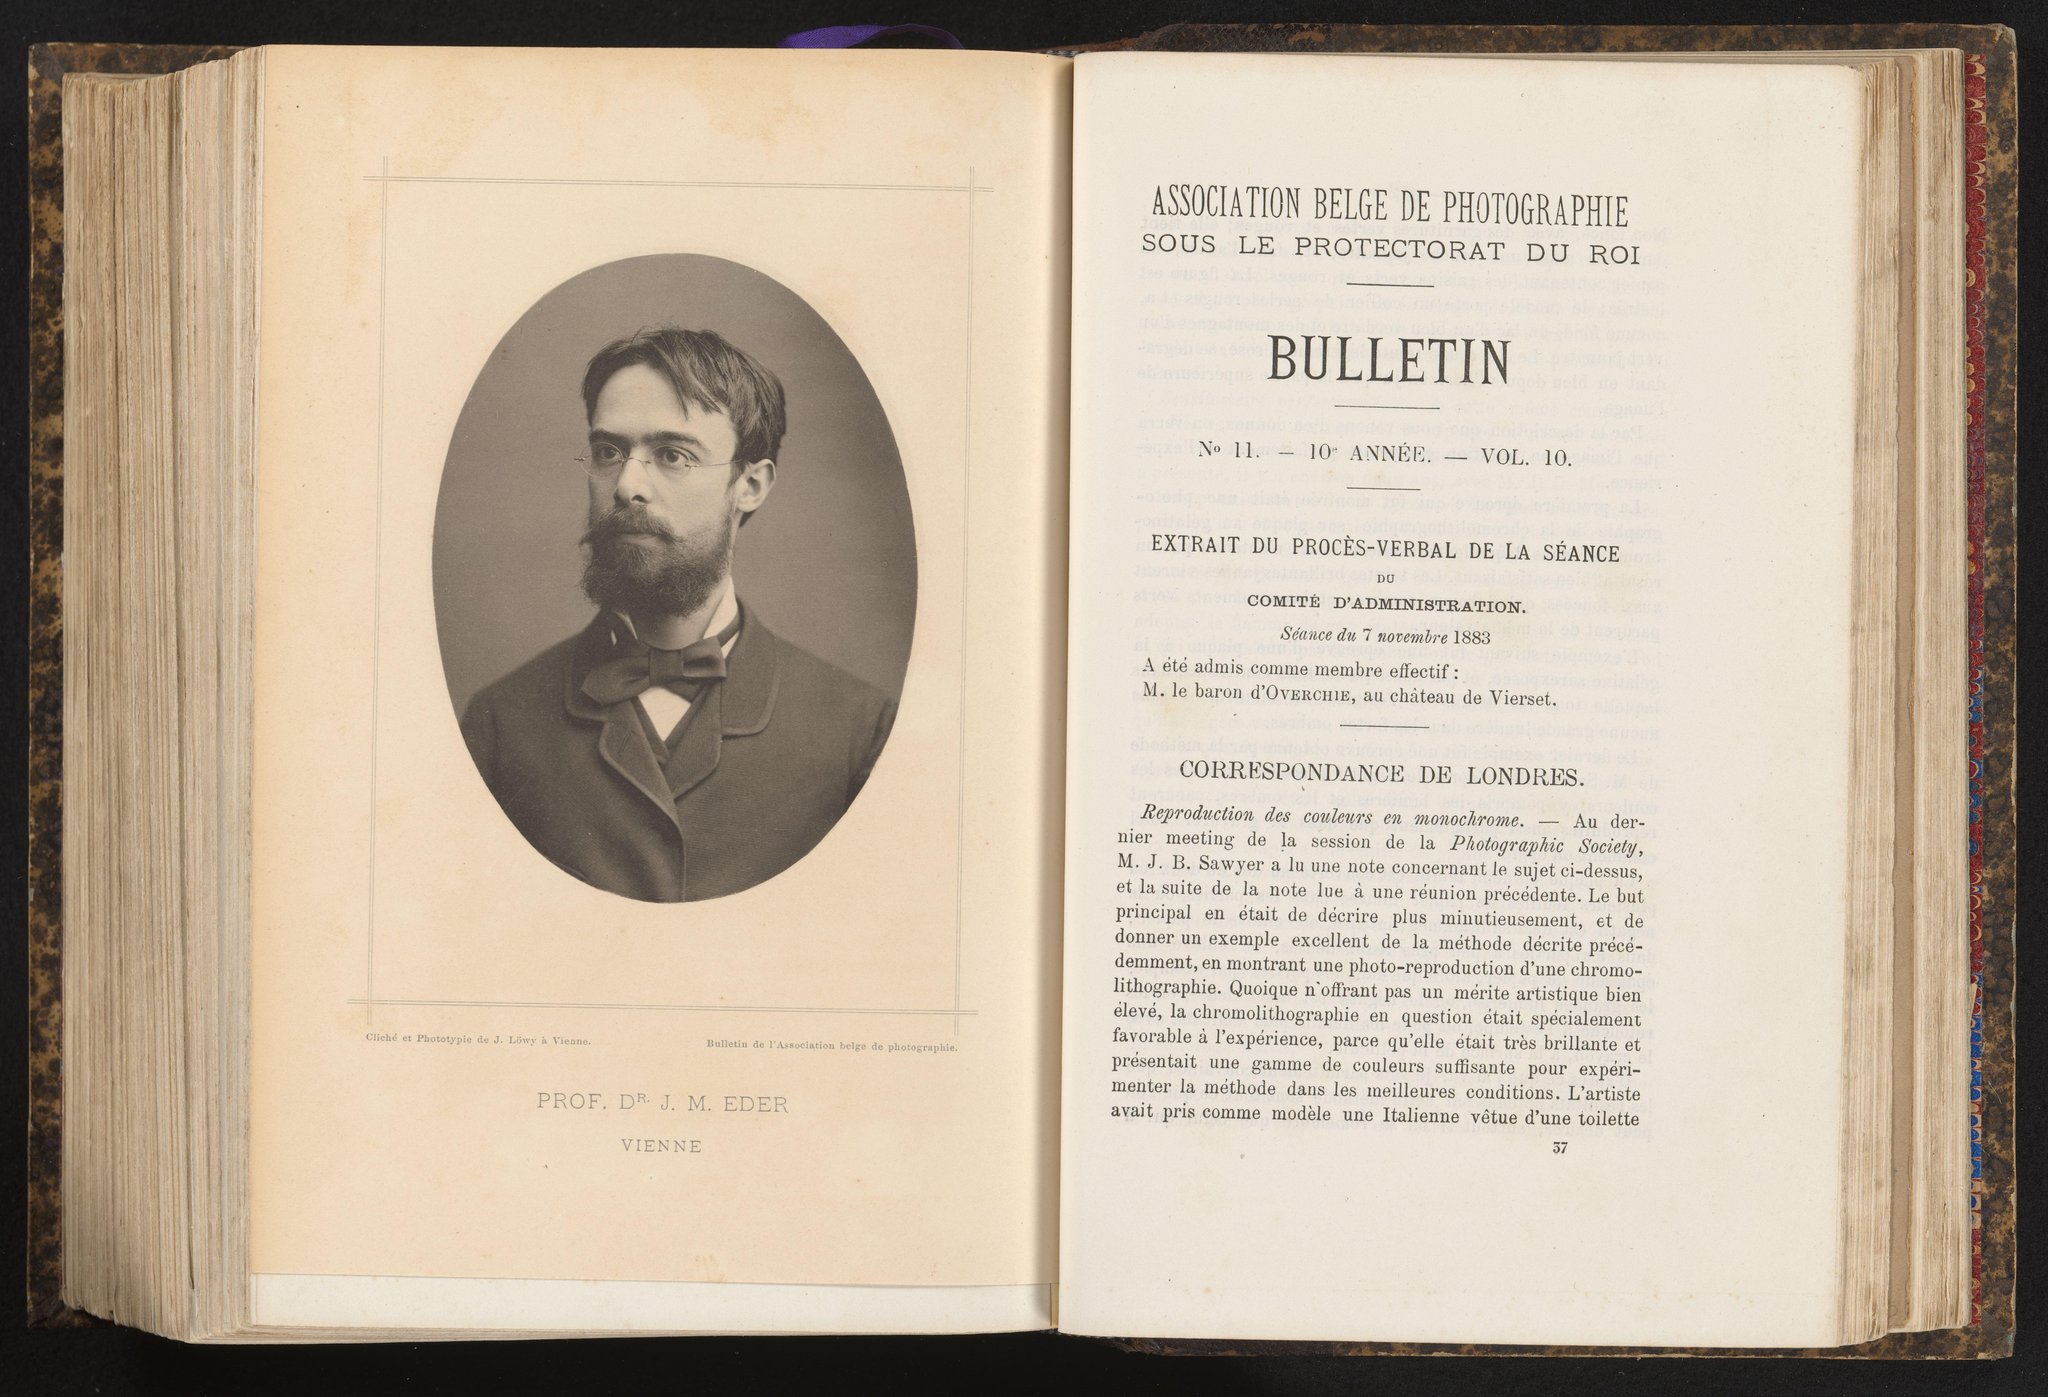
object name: photomechanical print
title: Portret van Josef Maria Eder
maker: josef löwy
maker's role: publisher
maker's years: 1835-1902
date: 1878-1883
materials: paper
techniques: photograph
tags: josef maria eder, adult man, historical persons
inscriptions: inscription: ‘Bulletin de l'Association belge de Photographie’